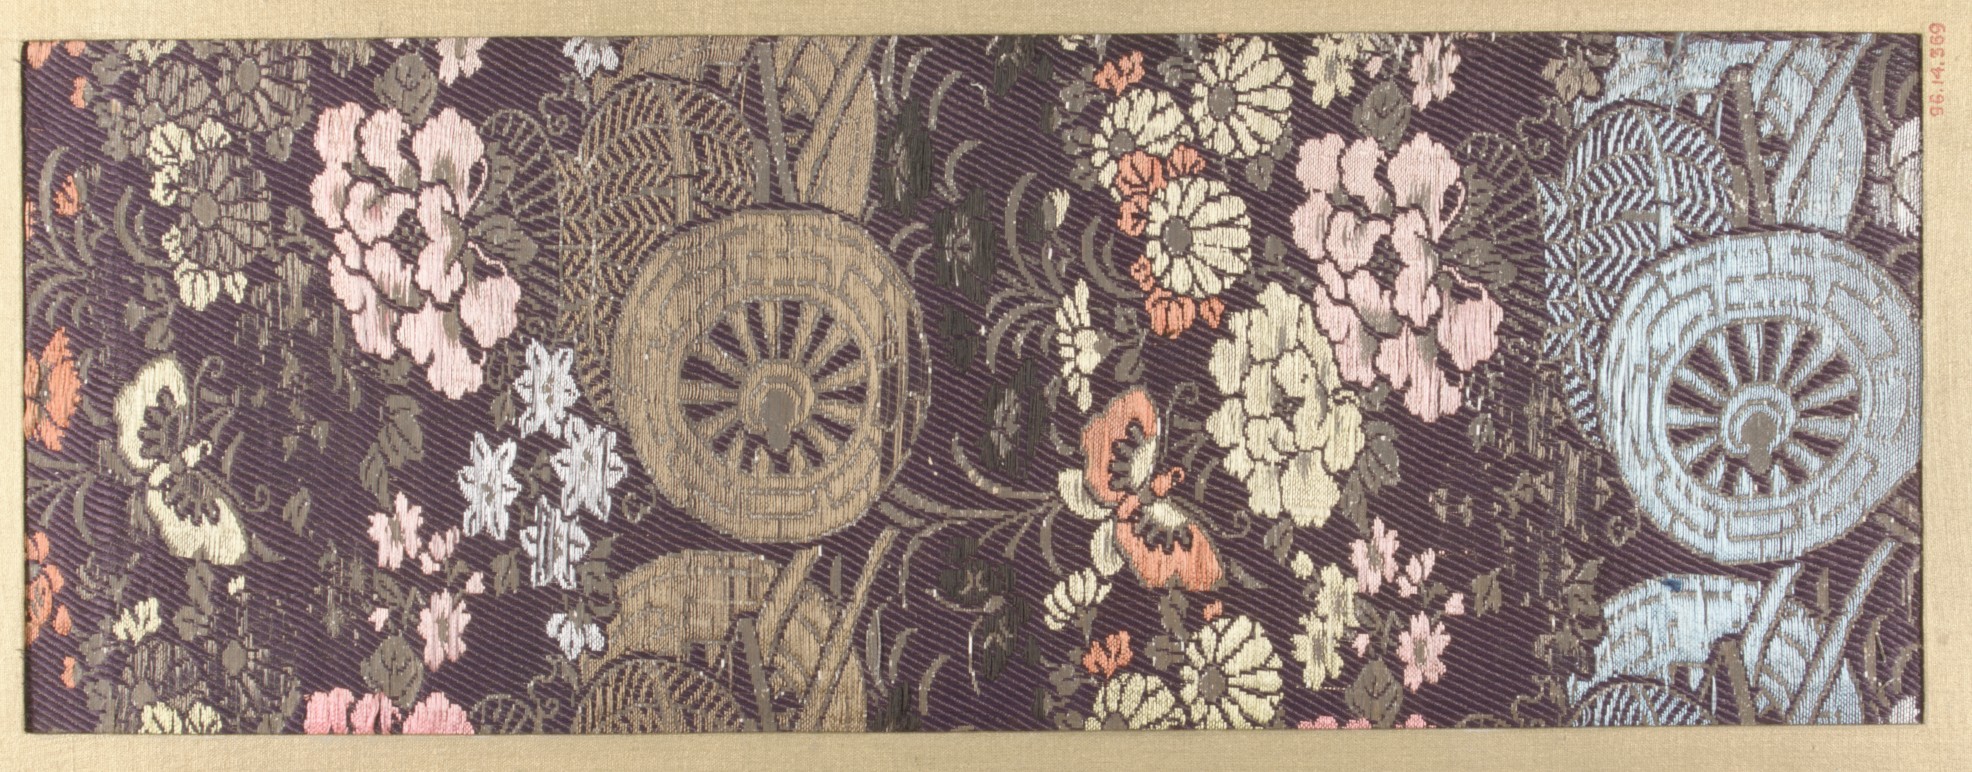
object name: piece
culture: japanese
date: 1701-1900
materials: silk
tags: butterflies,leaves